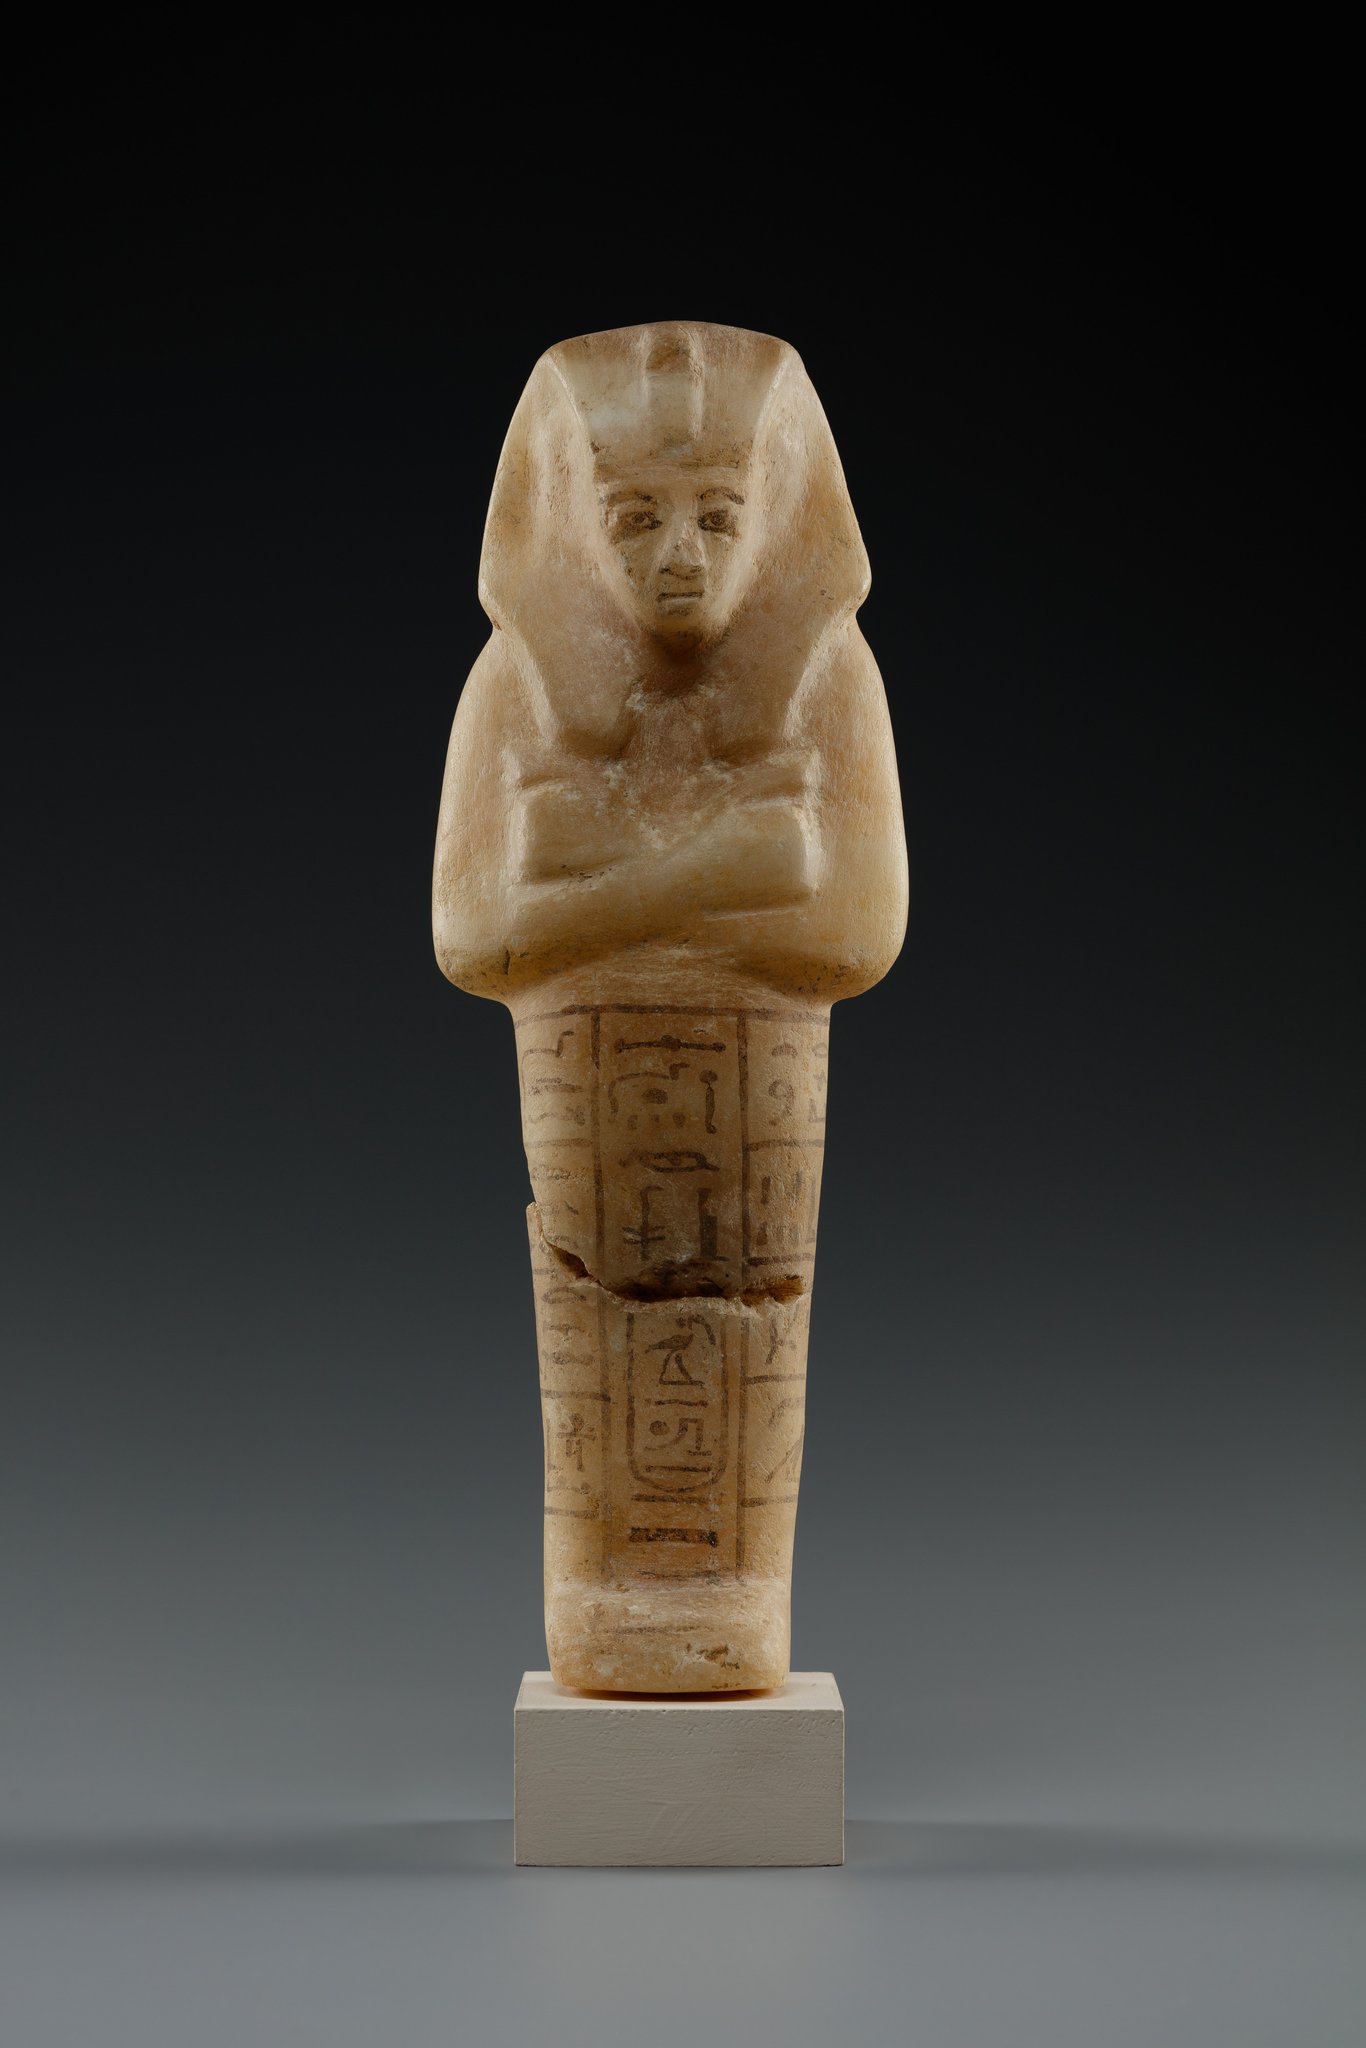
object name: shabti, siptah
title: Shabti of Siptah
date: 1194-1188 BCE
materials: stone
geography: egypt